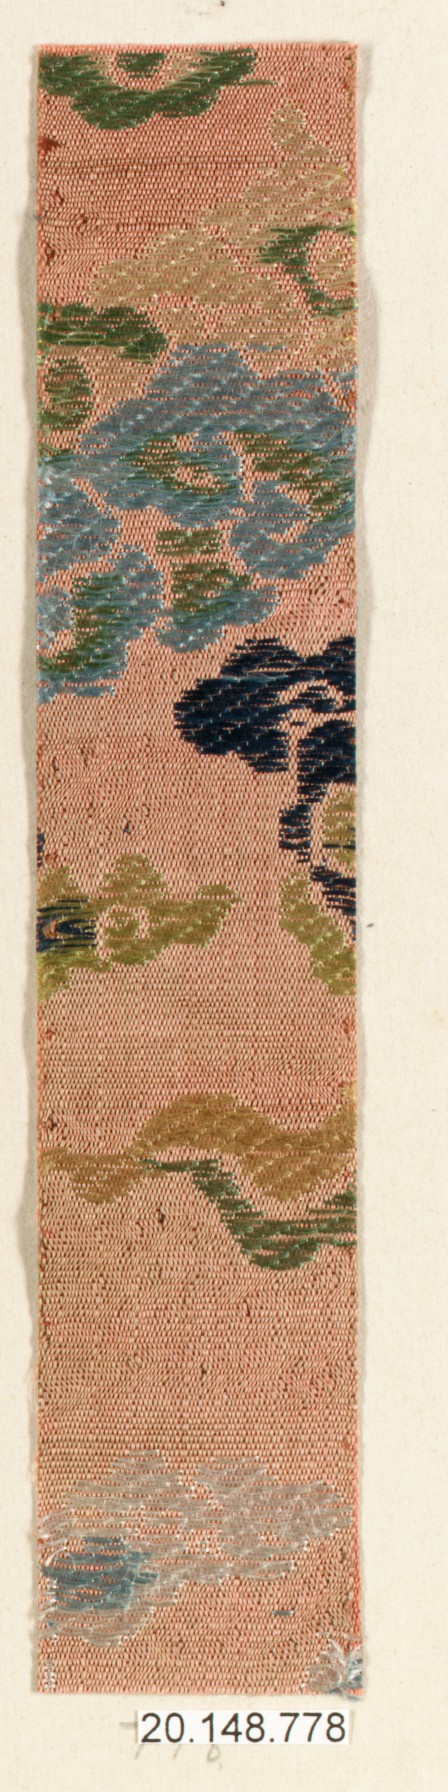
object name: piece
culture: japanese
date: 1601-1700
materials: silk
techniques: compound weave